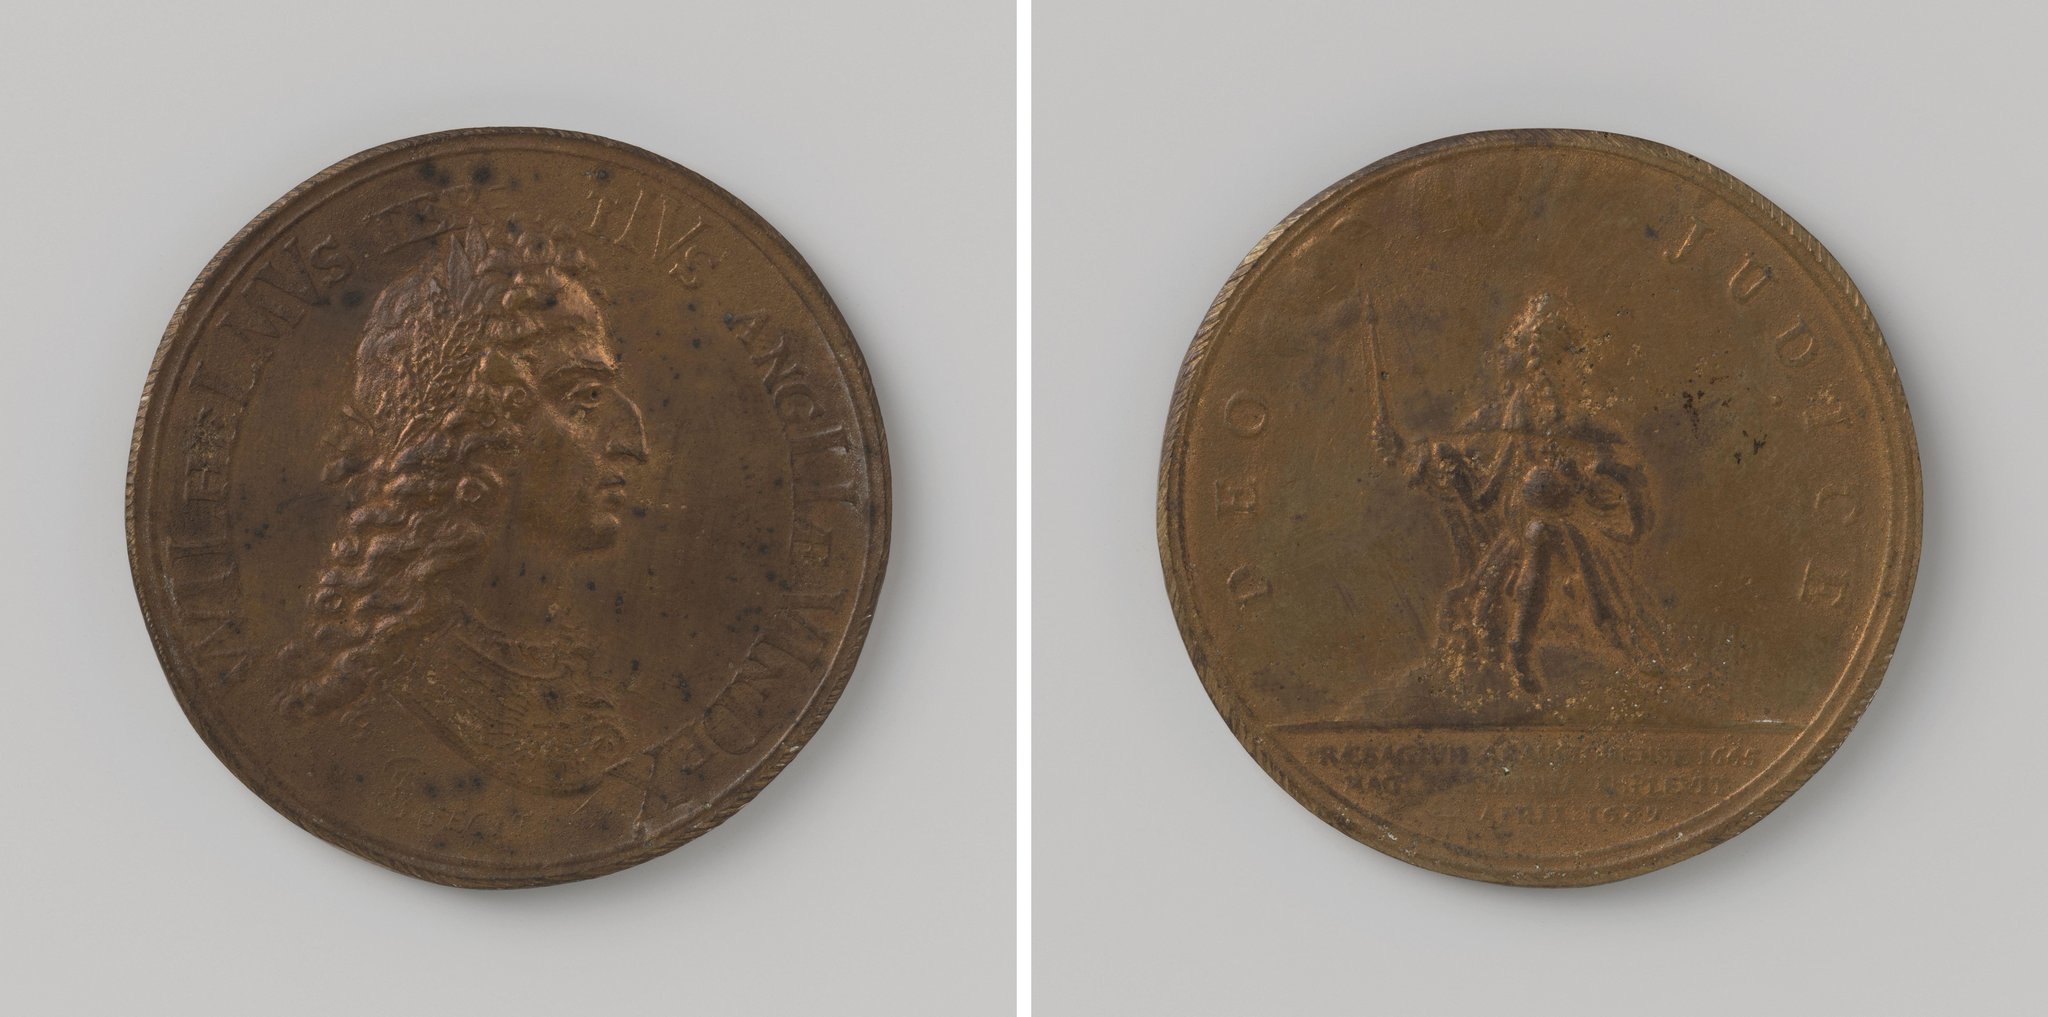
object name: history medal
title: Kroning van Willem III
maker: jan smeltzing (i)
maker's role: modelleur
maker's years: 1656-1693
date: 1689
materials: bronze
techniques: striking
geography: leiden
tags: the hague, william iii (prince of orange and king of england, scotland, and ireland)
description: Bronzen penning. Voorzijde: borststuk man met lauwerkrans binnen omschrift. Keerzijde: Willem III met kroon, rijksappel en scepter, knielend op globe, beschenen door zomerlicht binnen omschrift; afsnede: opschrift